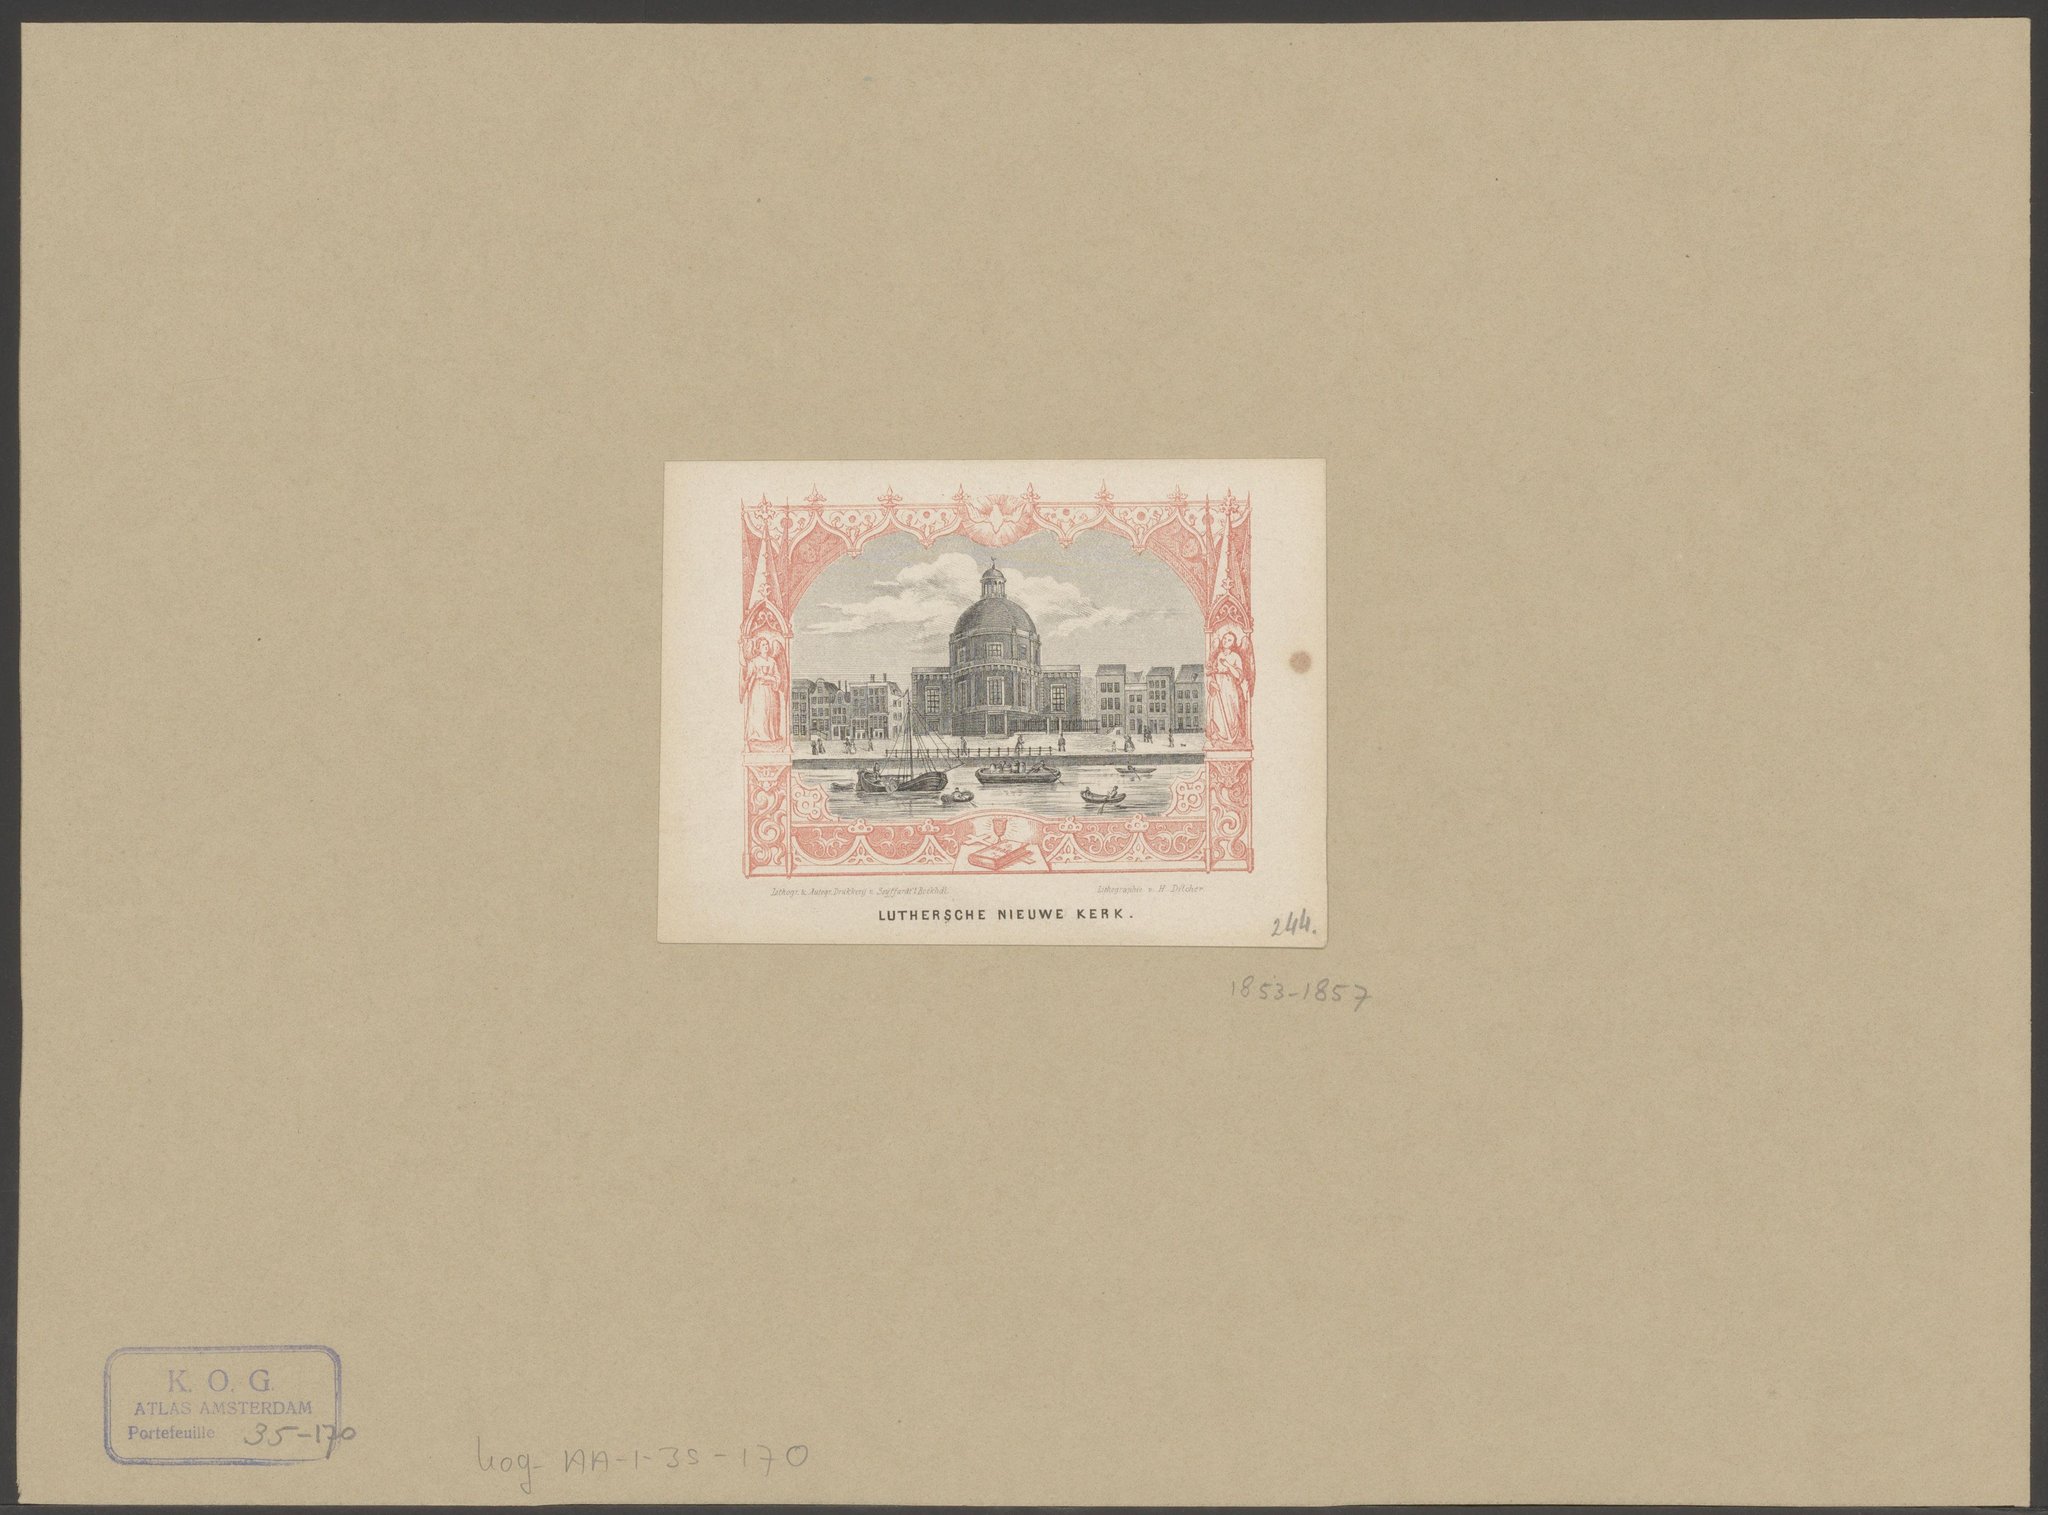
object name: print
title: Luthersche Nieuwe Kerk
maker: heinrich dilcher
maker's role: print maker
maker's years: 1824-1885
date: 1849-1885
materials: paper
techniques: letterpress printing, lithograph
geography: amsterdam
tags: canal, church (exterior)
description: Onderwerpsrubriek binnen de Atlas Amsterdam: Kerkwezen: Ev. Lutherse Gemeente: Ronde Luthersche Kerk na de herbouwing.